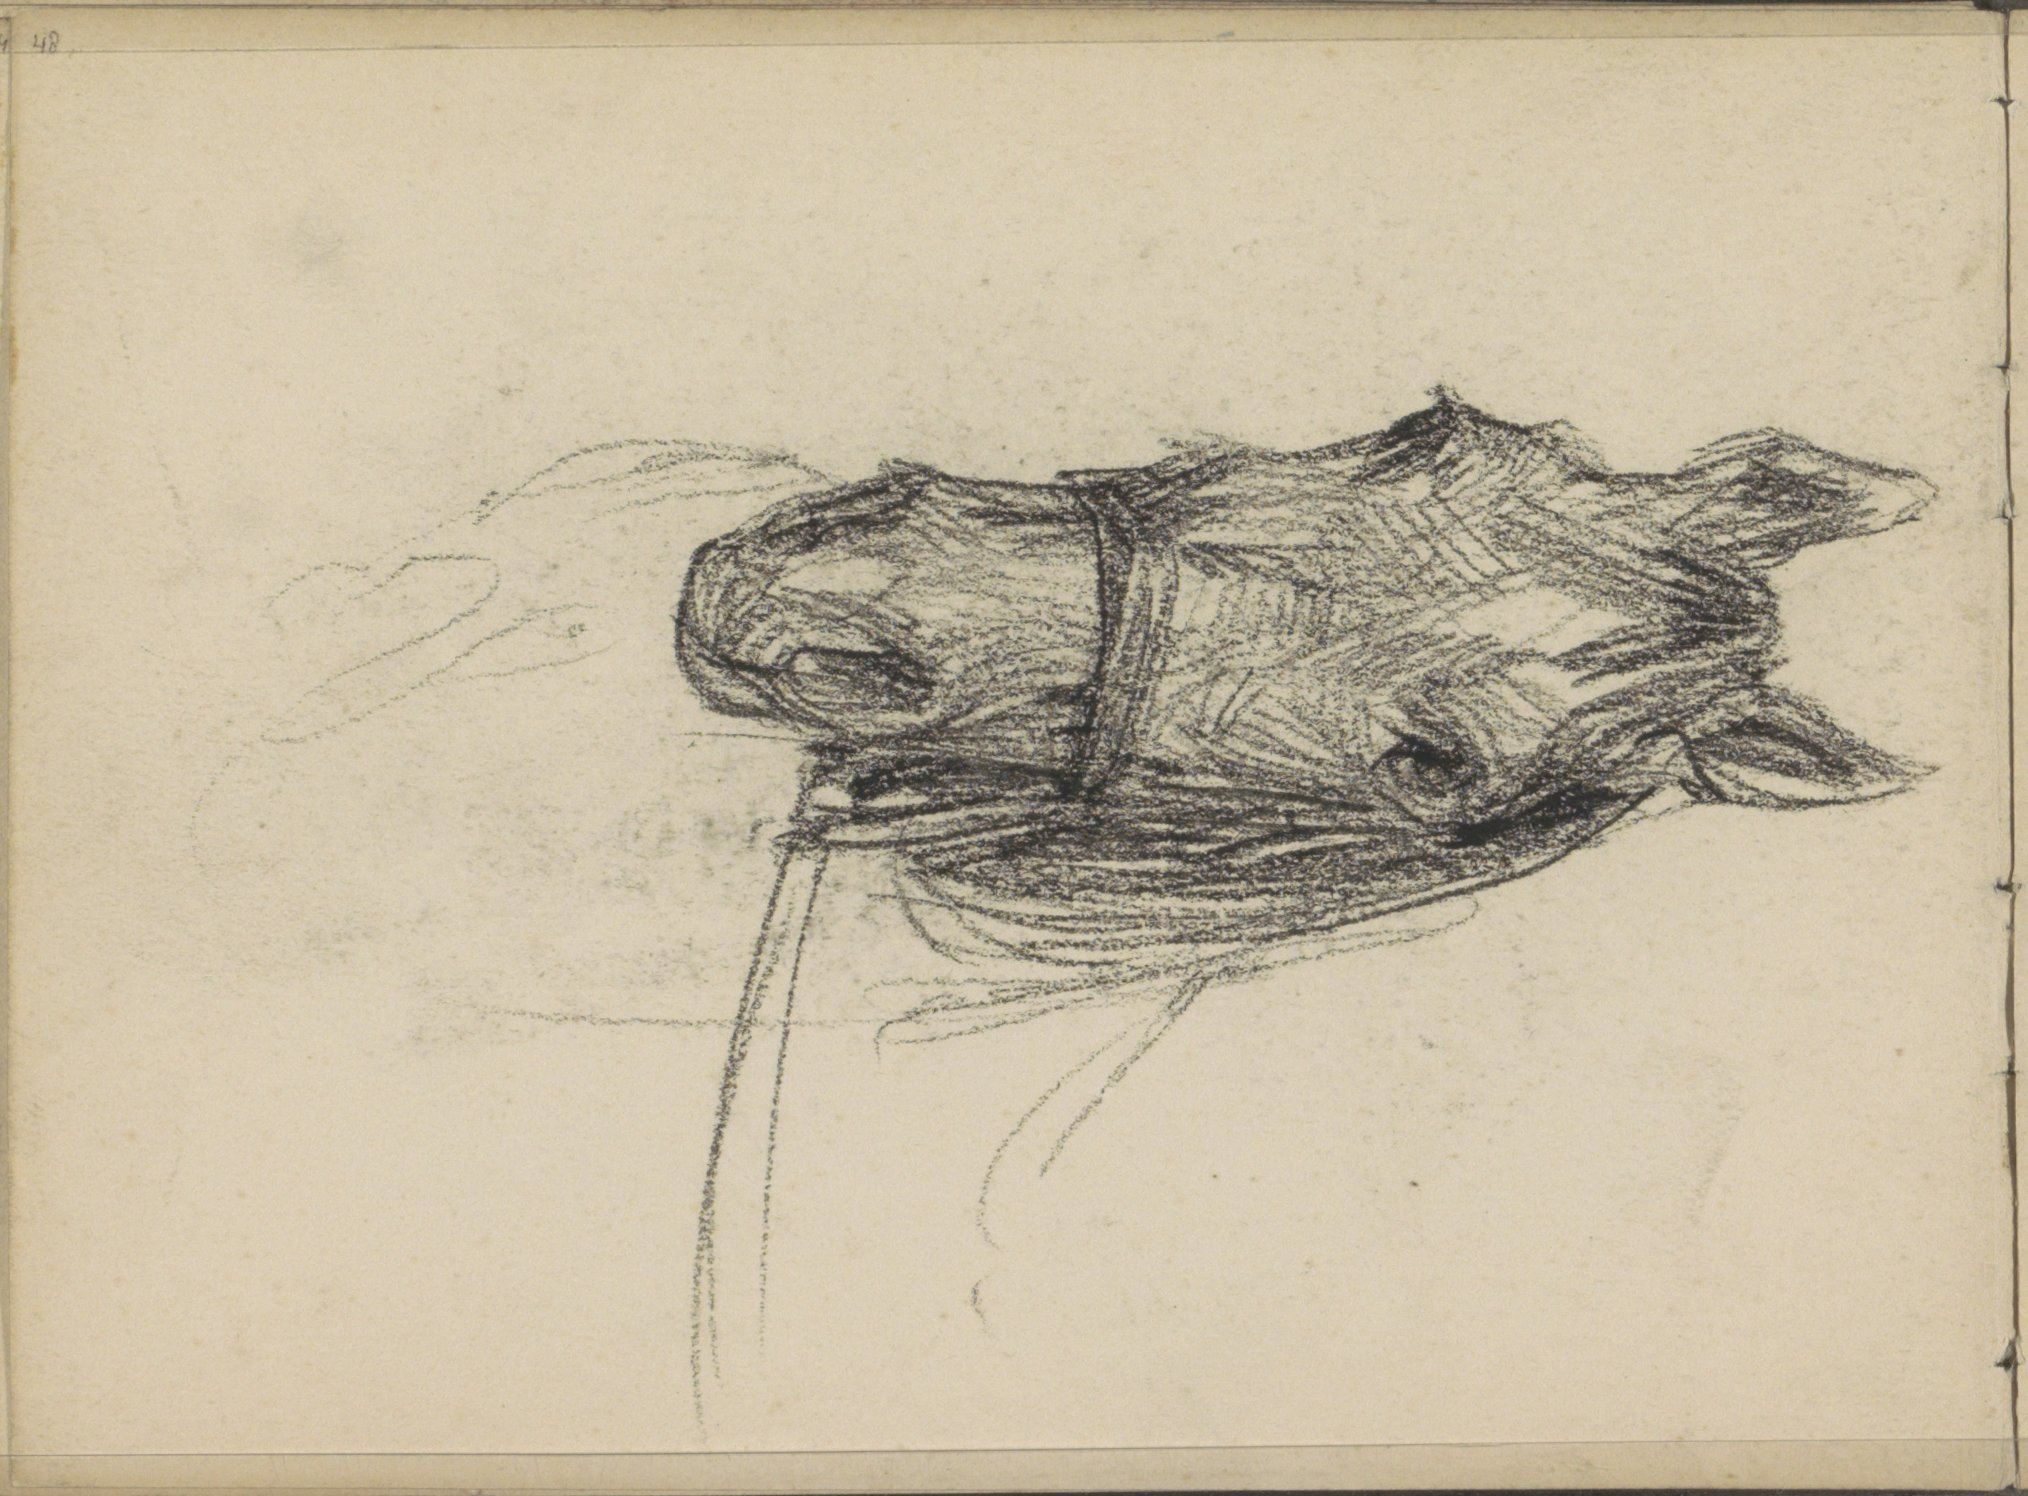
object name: sketchbook leaf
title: Paardenhoofd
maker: marius bauer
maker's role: draughtsman, print maker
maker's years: 1867-1932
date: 1879-1884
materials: chalk, paper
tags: horse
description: Pagina 48 uit een schetsboek met 28 bladen.